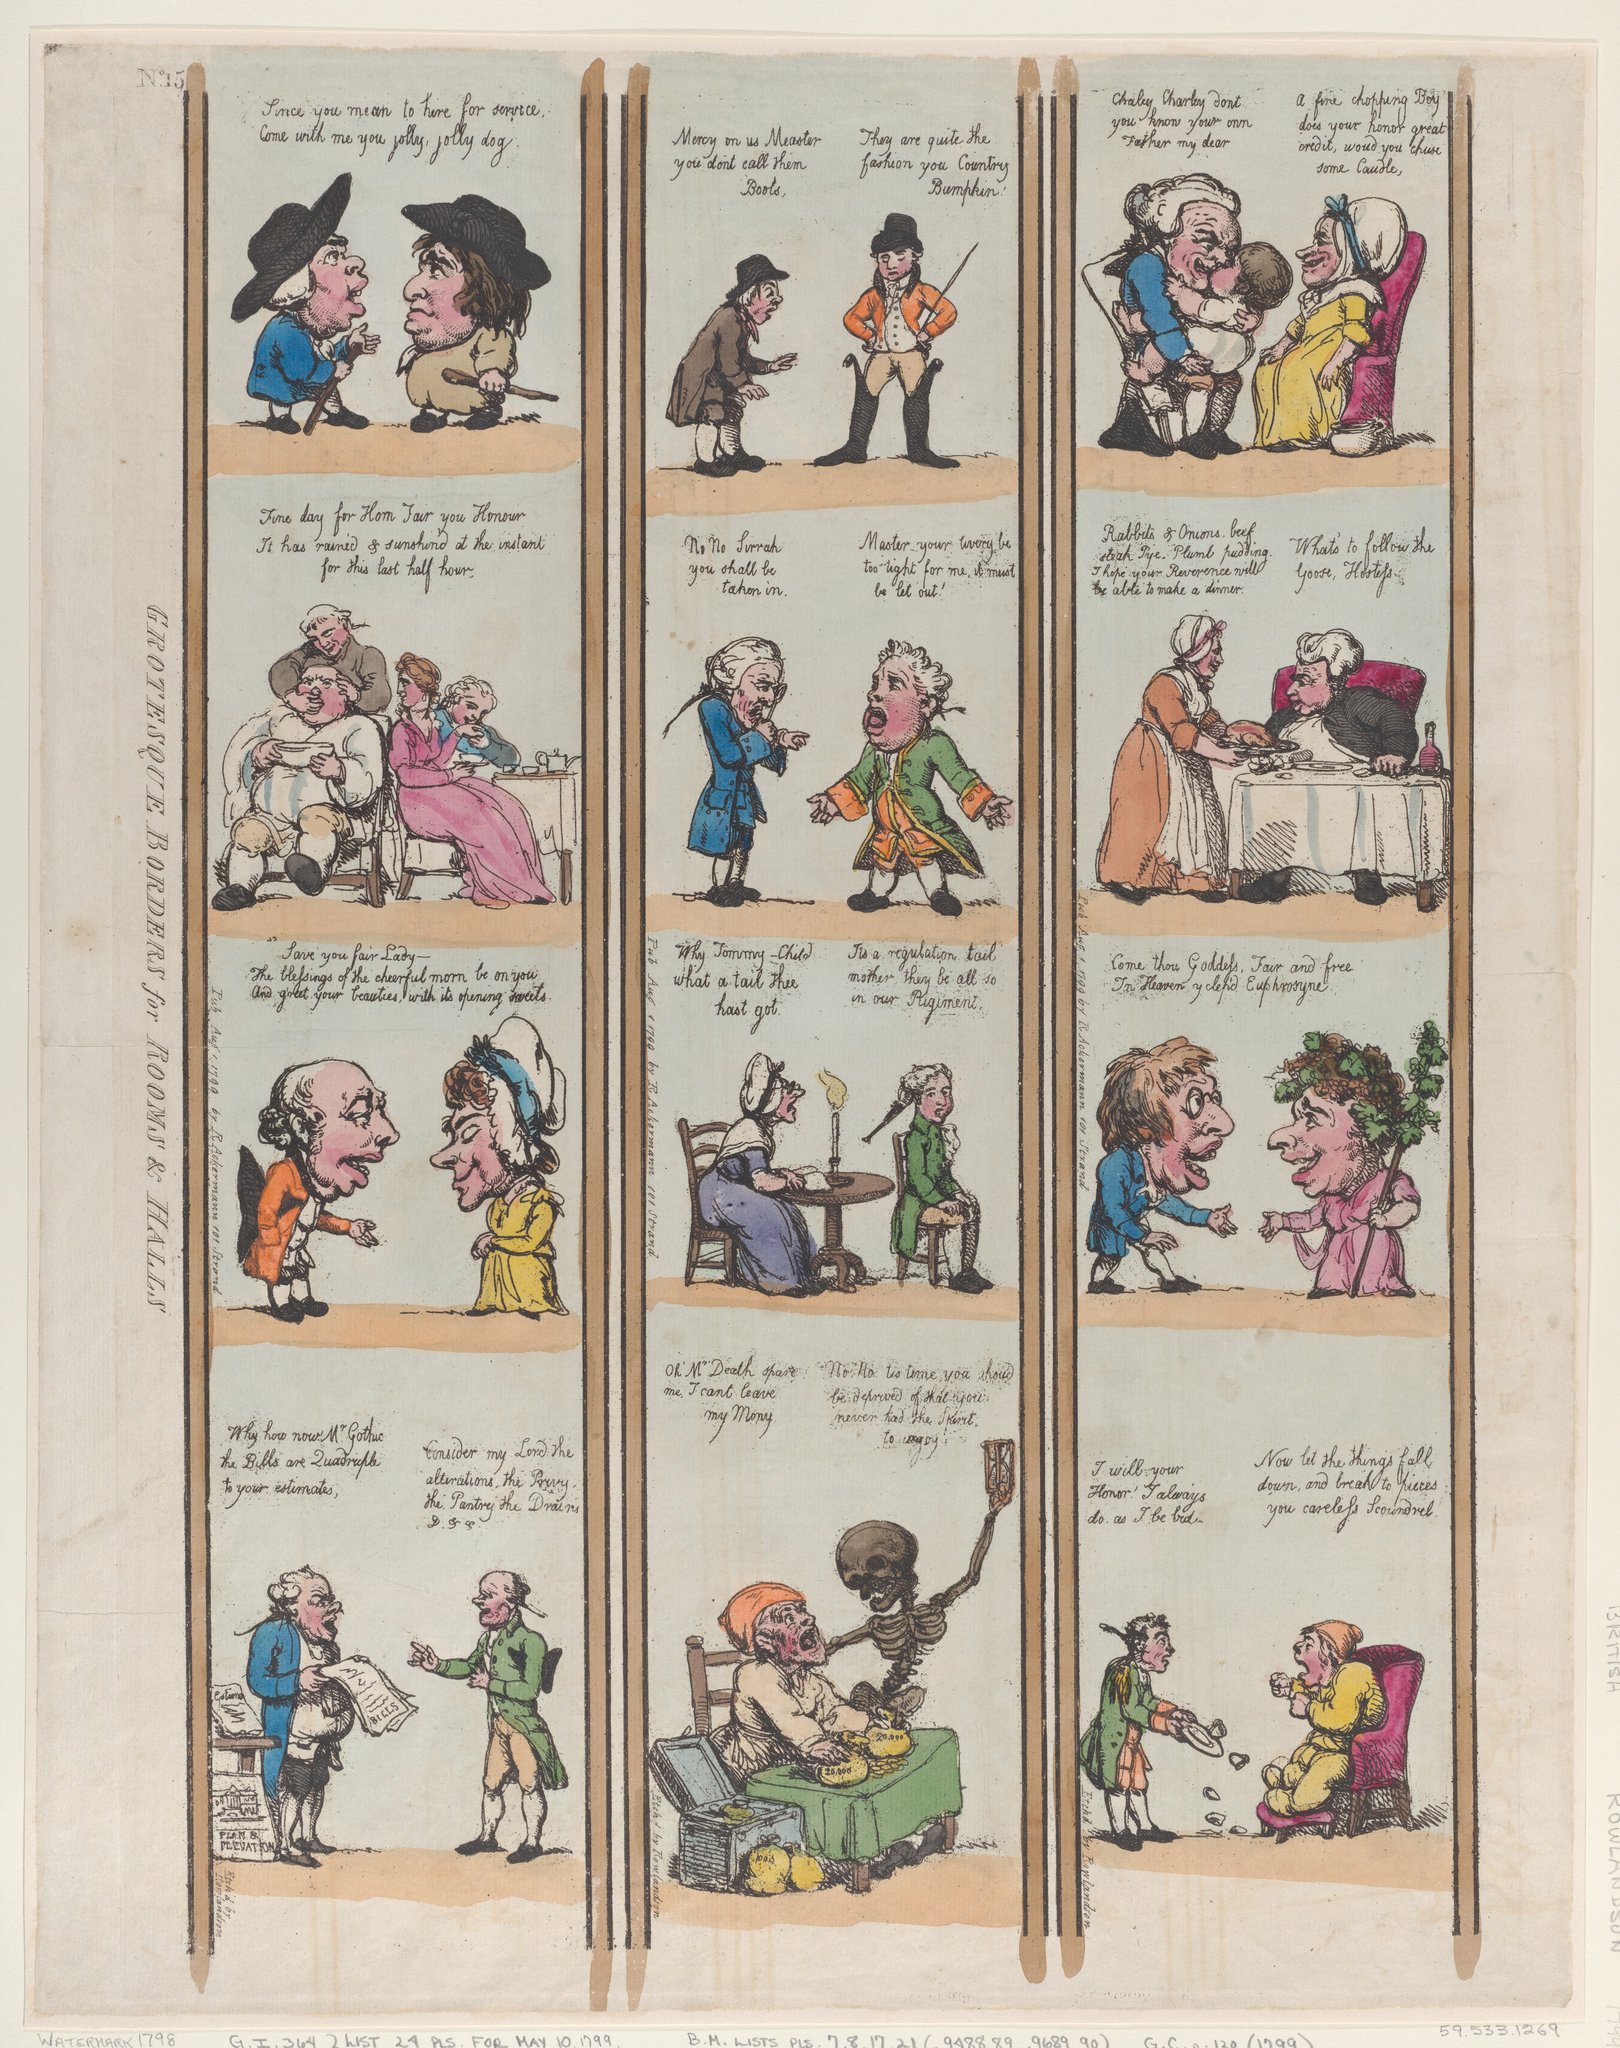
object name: print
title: Grotesque Borders for Rooms & Halls, Plate 15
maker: thomas rowlandson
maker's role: artist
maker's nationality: british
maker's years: 1757-1827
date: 1799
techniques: etching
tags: satire,skeletons,men,women